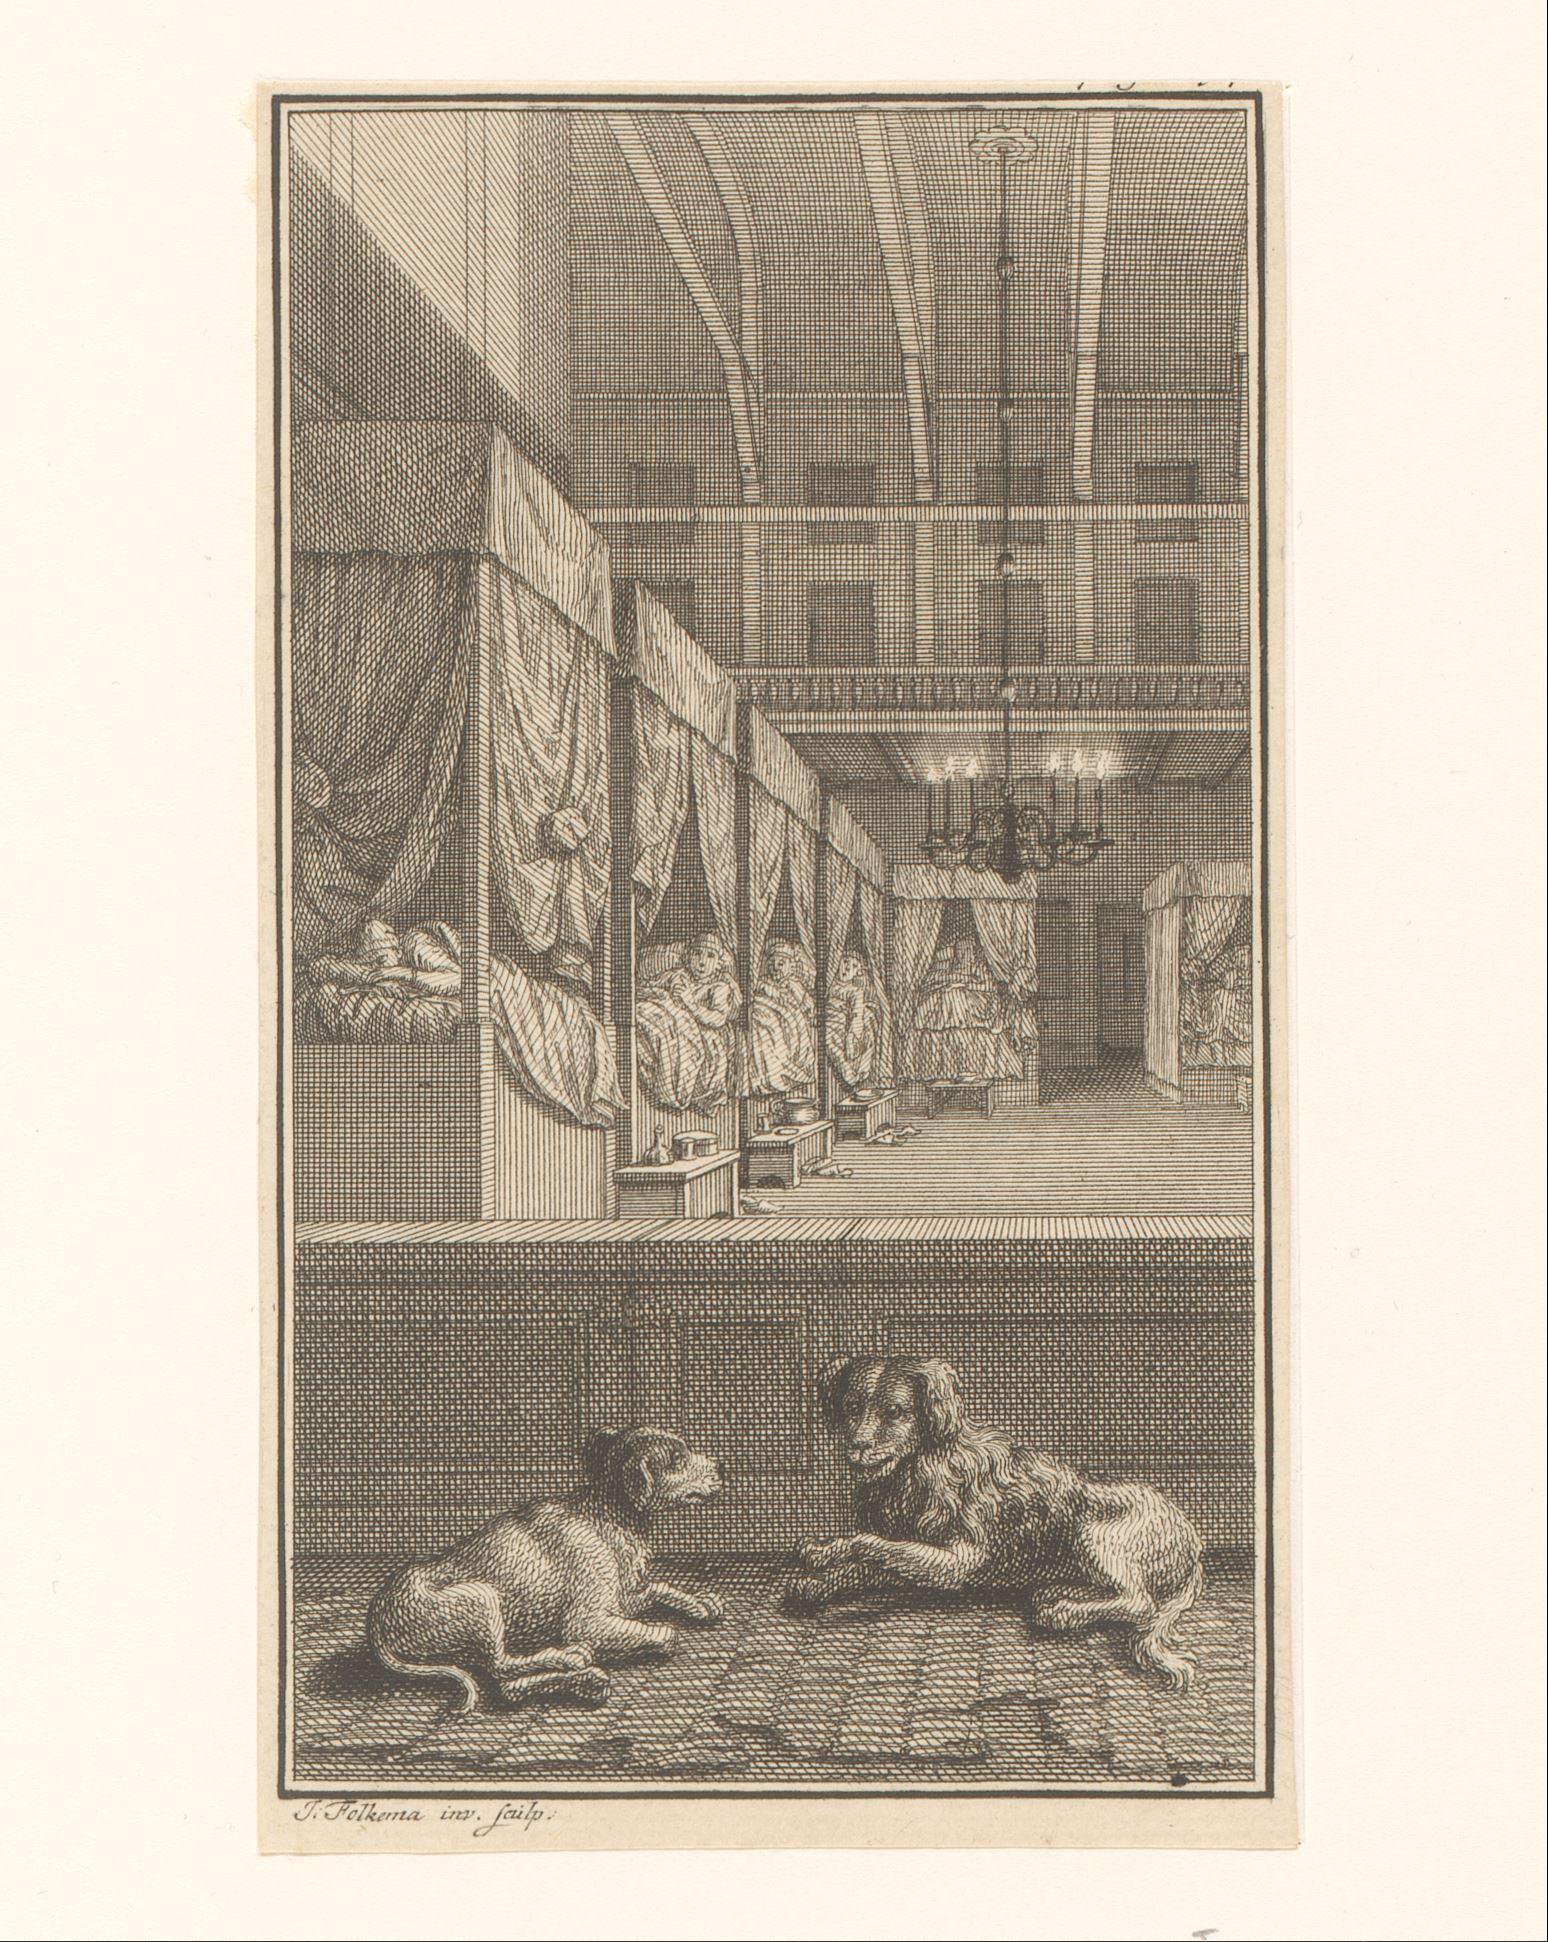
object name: print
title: Slaapzaal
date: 1739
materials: paper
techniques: etching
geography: the hague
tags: ward; room (in hospital), dog, amsterdam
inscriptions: collector's mark: Lugt 2228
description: Een slaapzaal in een ziekenhuis waar figuren in slaapkleding in bedden liggen die langs de muur staan opgesteld. Op de voorgrond liggen twee honden.